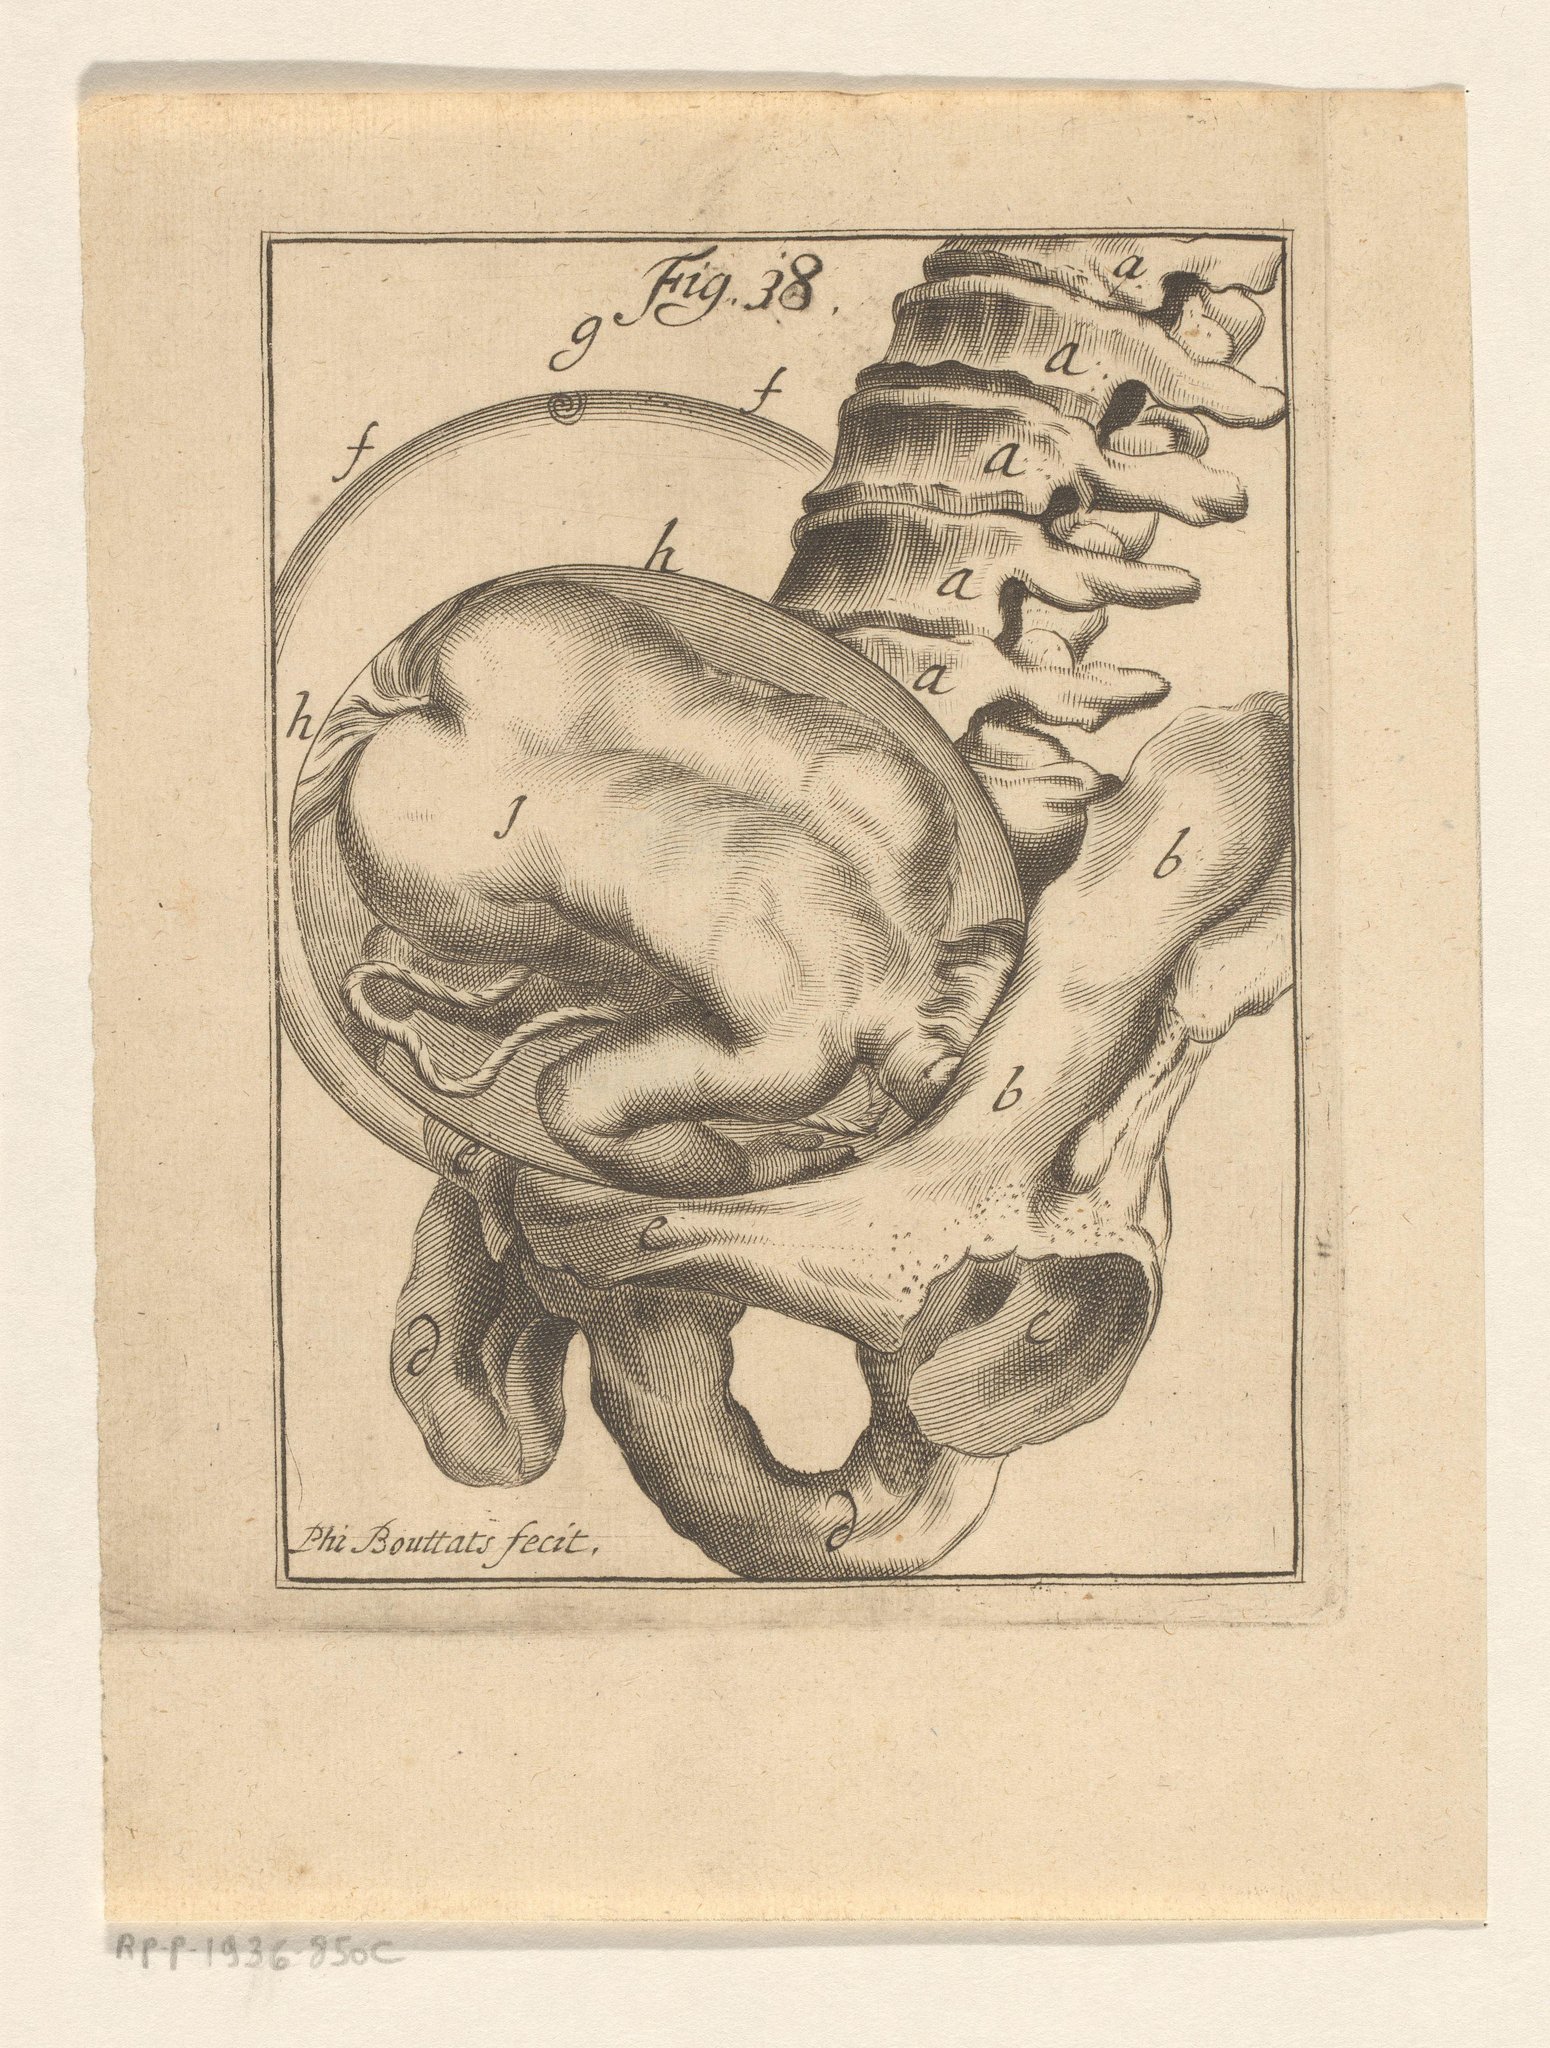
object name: book illustration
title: Dwarsligging van een foetus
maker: philibert bouttats (ii)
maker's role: print maker, publisher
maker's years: 1675-1750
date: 1701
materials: paper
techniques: engraving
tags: lying-in room, confinement, birth, physiology and anatomy ~ urogenital system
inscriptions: collector's mark: Lugt 2760, collector's mark: Lugt 2228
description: Een boekillustratie van een foetus in dwarsligging in de baarmoeder. Zijaanzicht met alleen de baarmoeder, heupen en ruggengraat van het skelet. De prent bevat bijhorende letters, die waarschijnlijk verwijzen naar notaties in het boek.